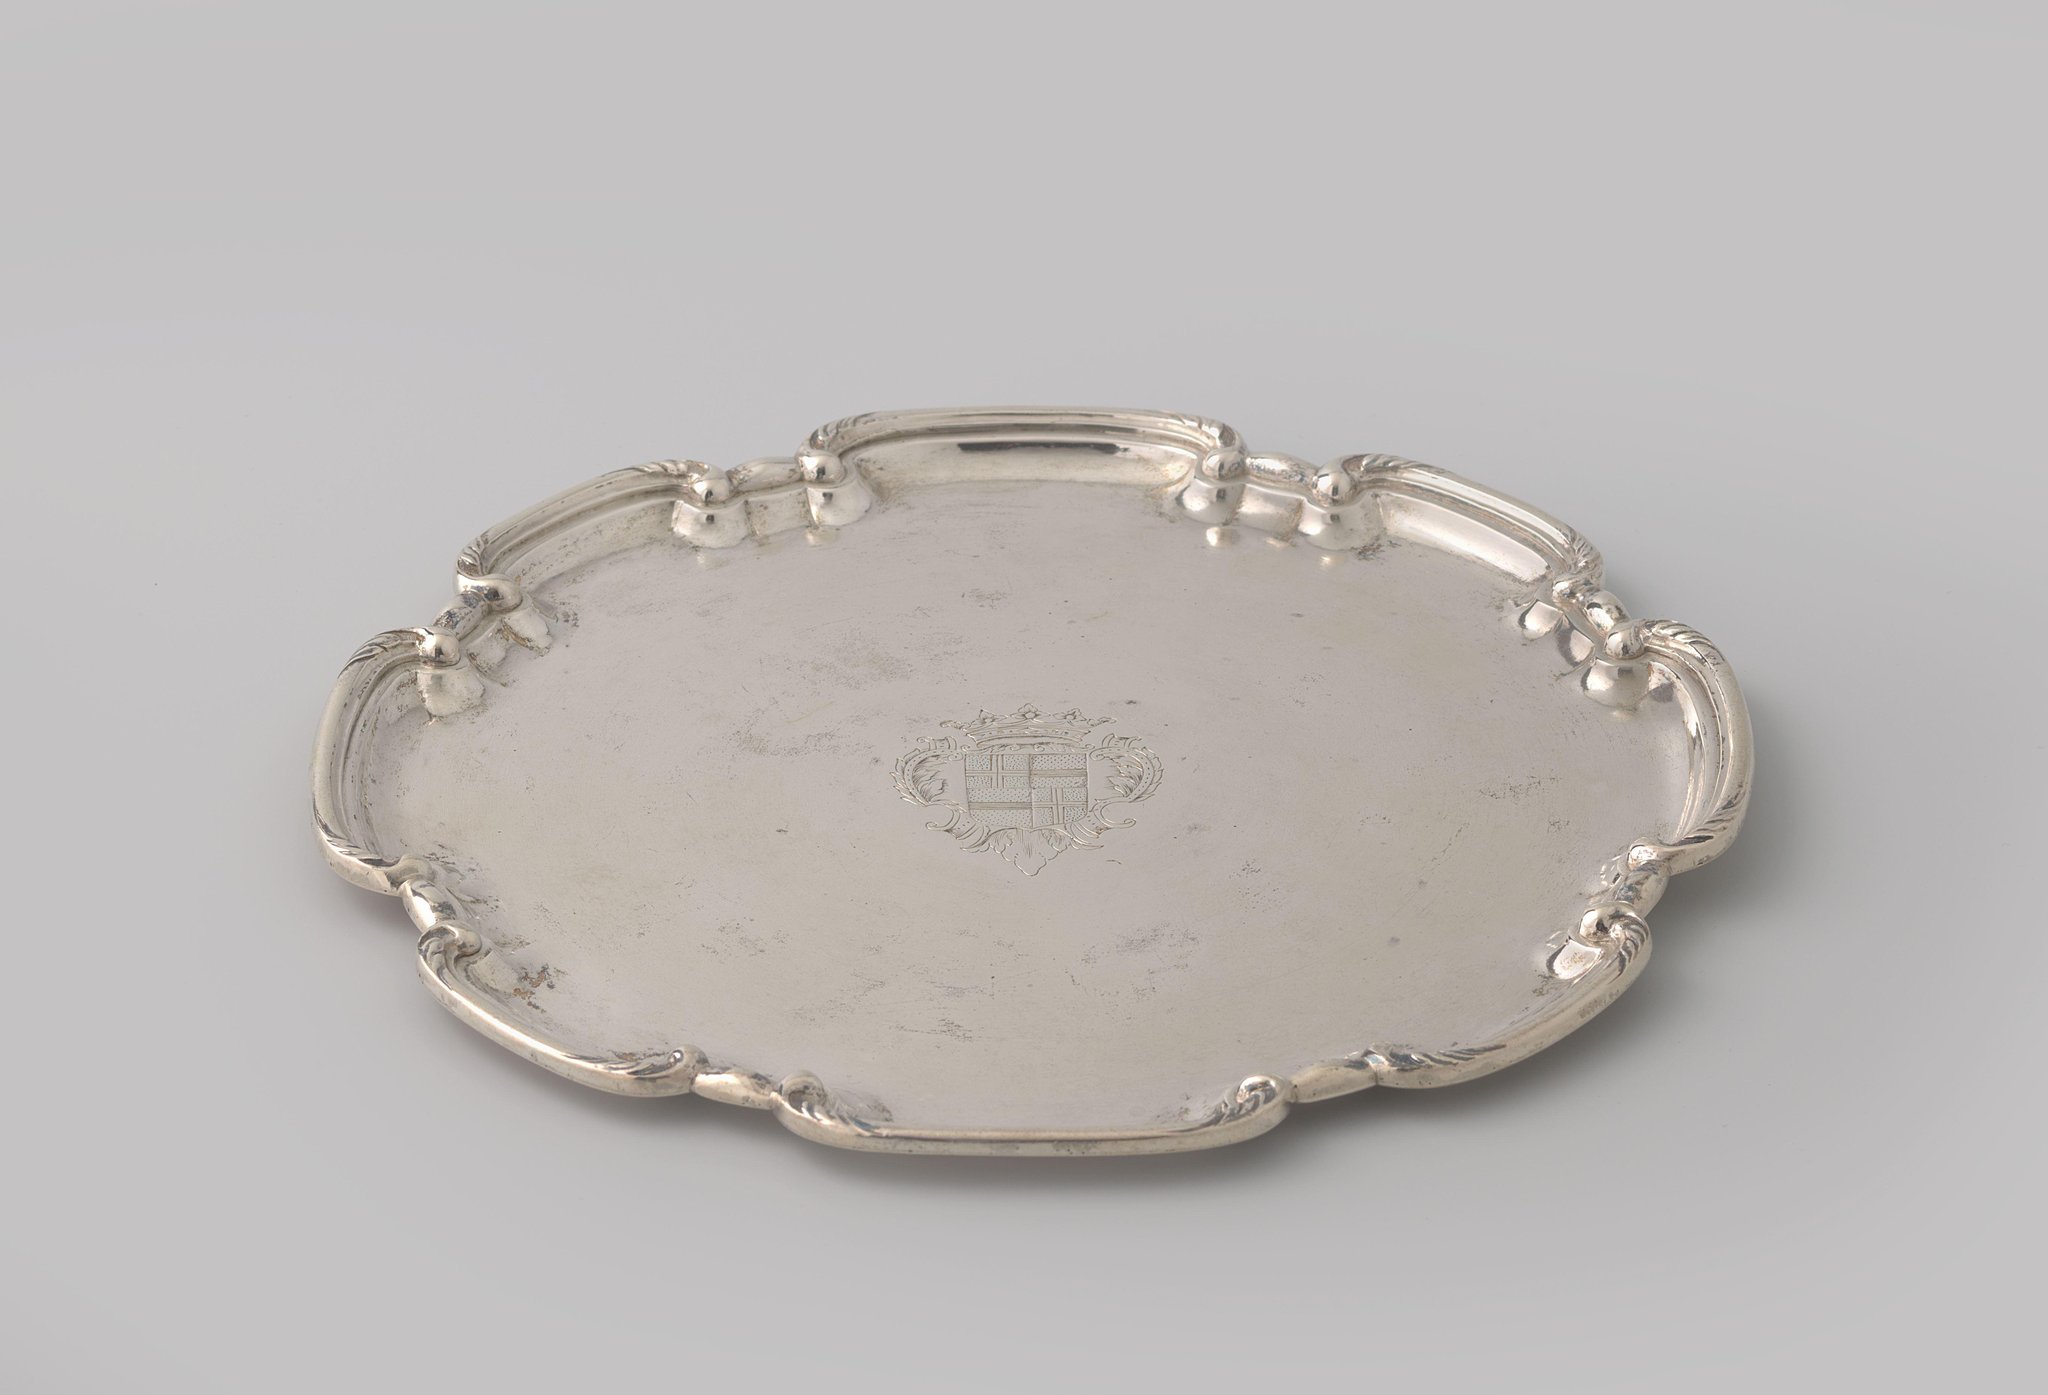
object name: salver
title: Presenteerblad van zilver met gedecoreerde rand. In het midden een gegraveerd gekroond wapen, mogelijk van de familie Van Bijlandt.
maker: johannes bos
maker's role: silversmith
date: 1732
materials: silver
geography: deventer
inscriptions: date letter: ‘2H (Ter Molen 1997, p. 199)’, maker's mark: ‘I.B (Ter Molen 1997, p. 202 )’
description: Tray. Silver. Deventer, 1732, by Johannes Bos.